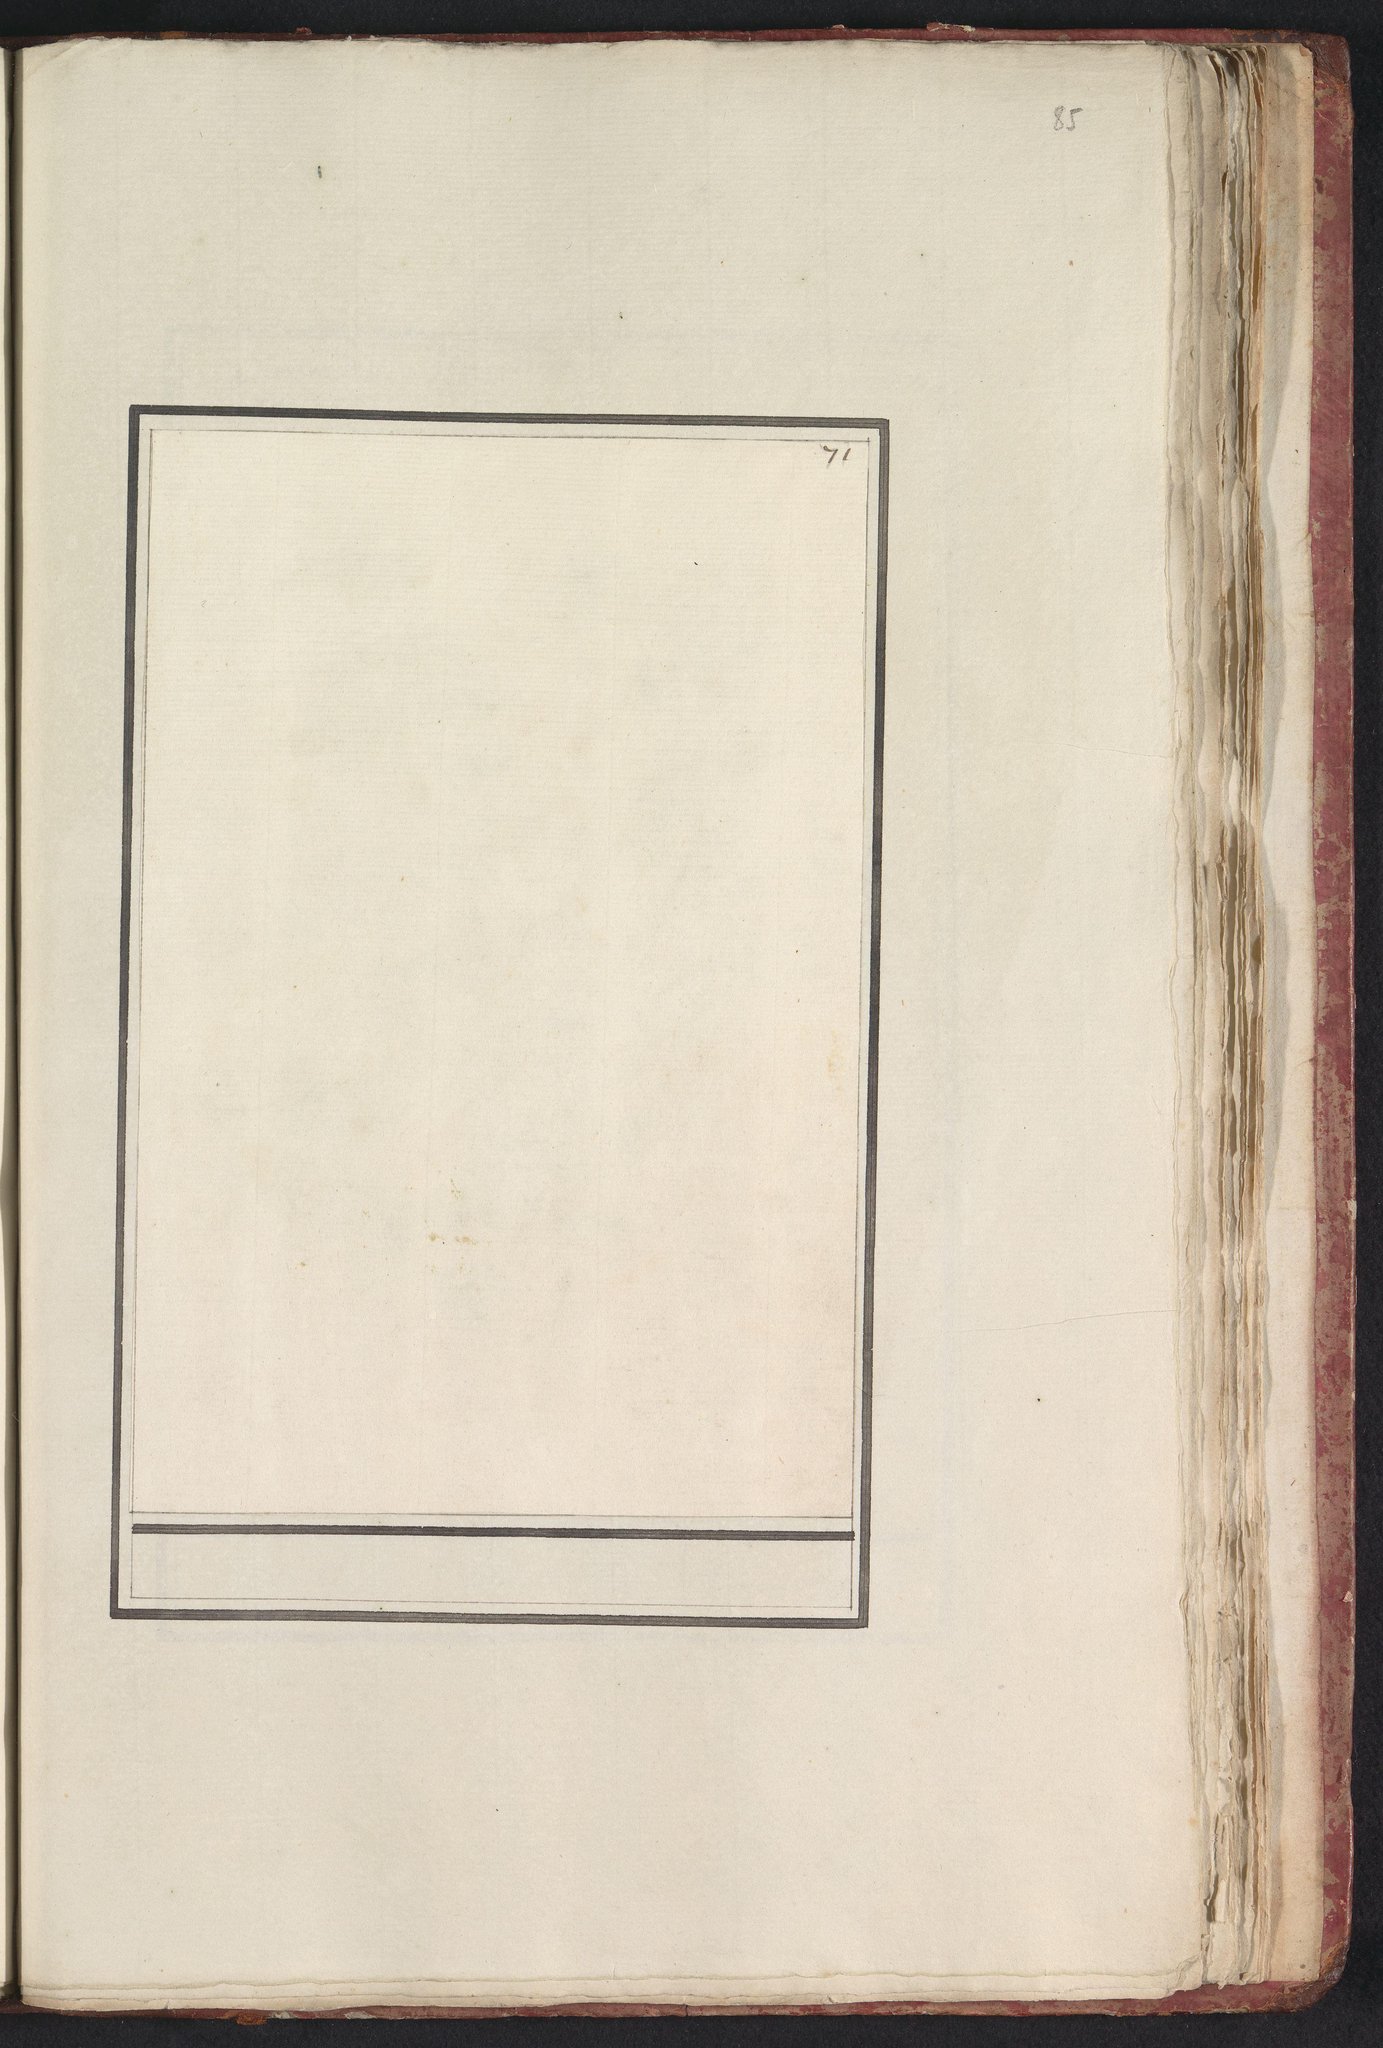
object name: drawing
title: Omlijsting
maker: Anonymous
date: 1809-1814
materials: ink, paper, pencil, watercolor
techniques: brush, pen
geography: southern netherlands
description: Lege omlijsting. Genummerd rechtsboven: 71. Onderdeel van het eerste album met tekeningen van bloemen en planten. Achtste van twaalf albums met tekeningen van dieren, vogels en planten bekend rond 1600, gemaakt in opdracht van keizer Rudolf II. Met toelichting in Nederlands, Latijn en Frans.